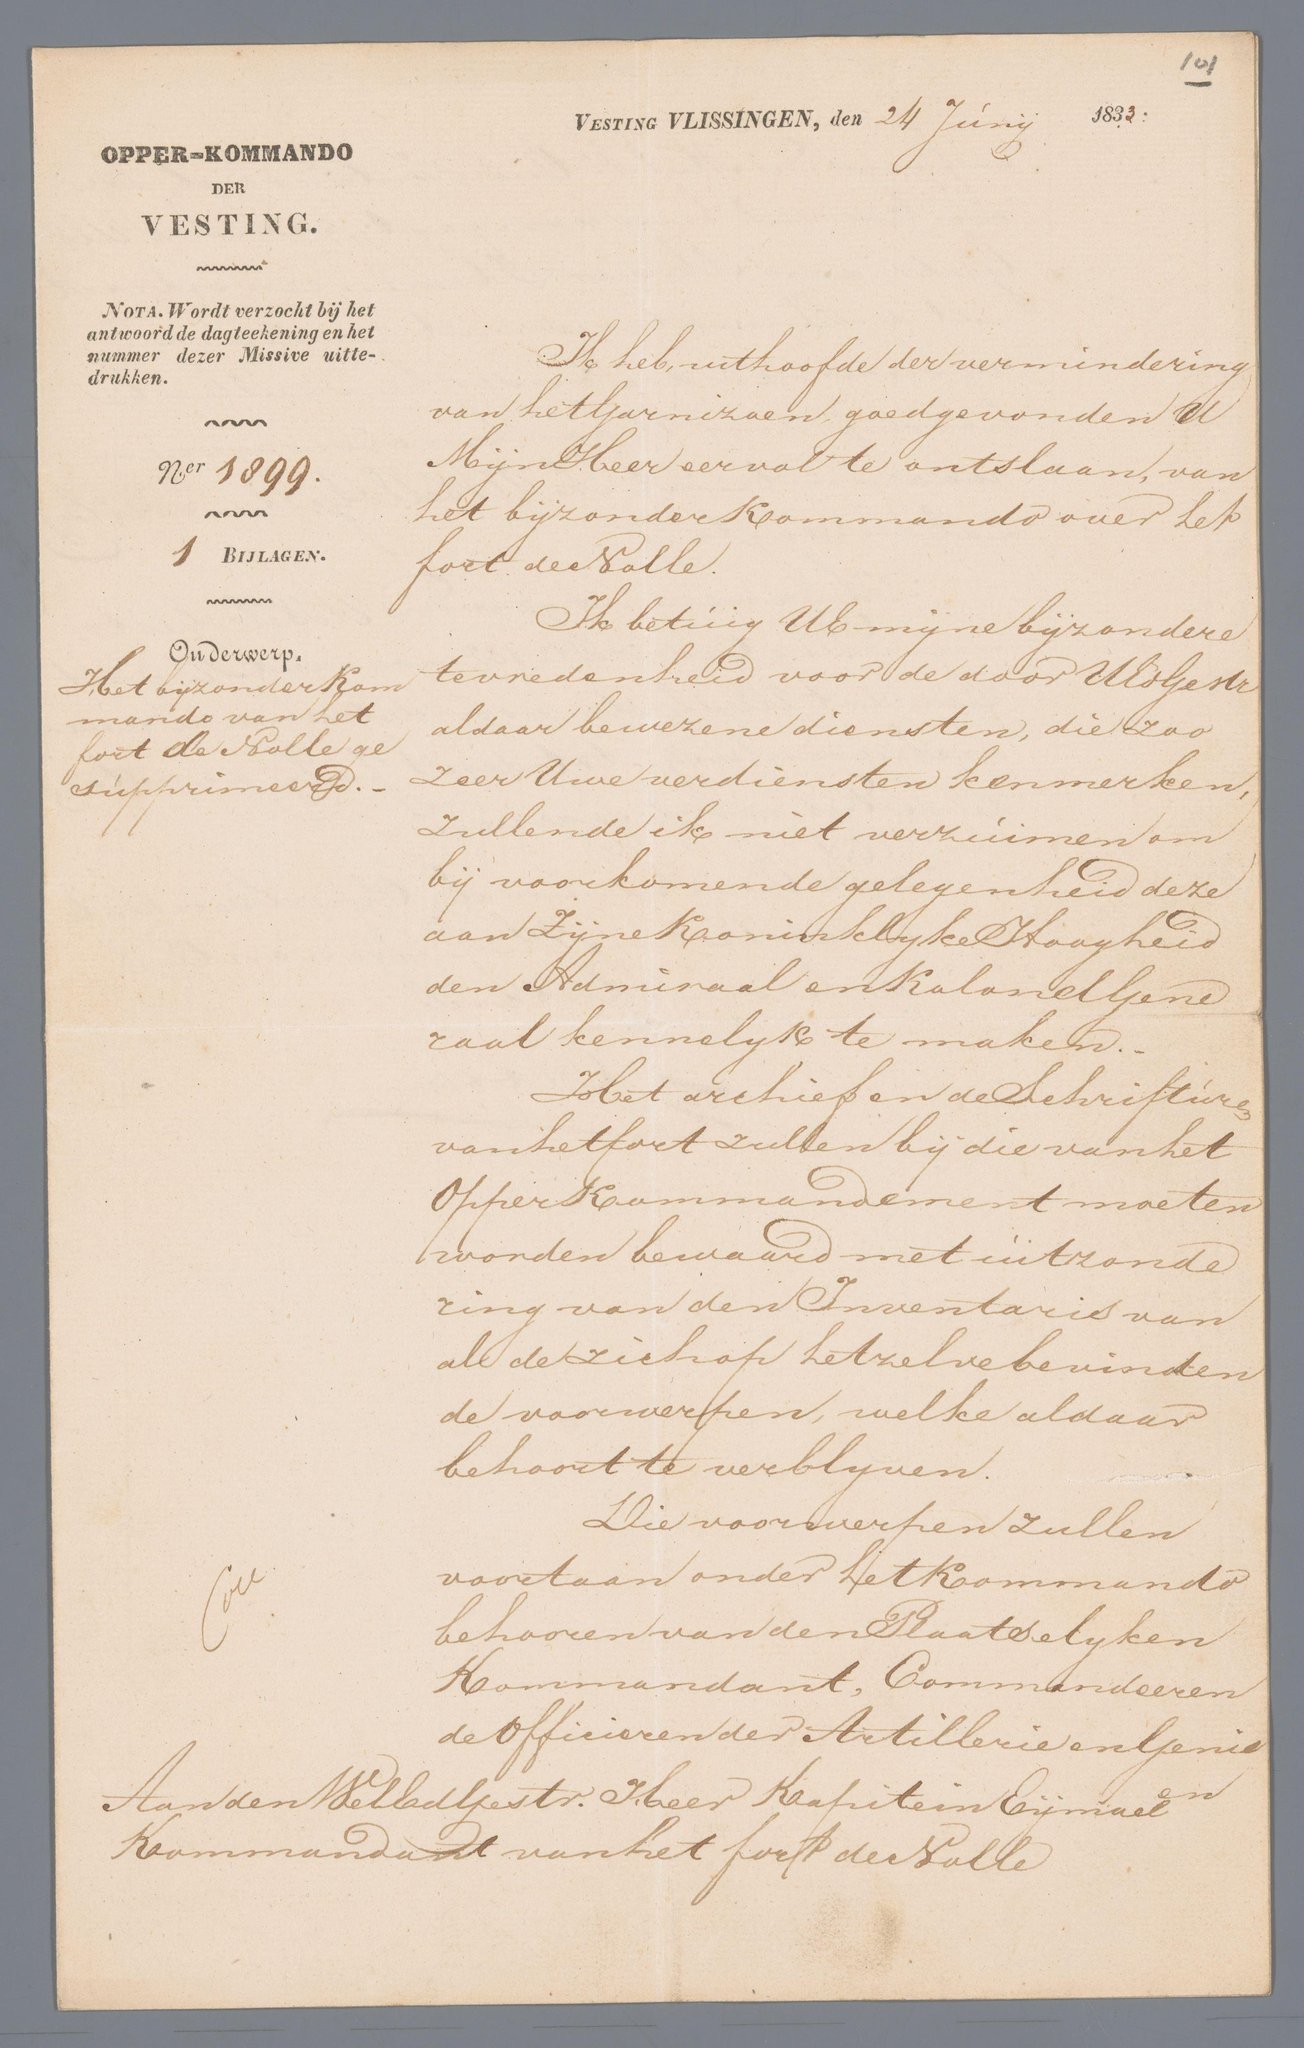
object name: letter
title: Brief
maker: gobius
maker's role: vice-admiraal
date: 1833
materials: ink, paper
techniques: printing, writing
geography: flushing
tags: kapitein, eijmael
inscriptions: date